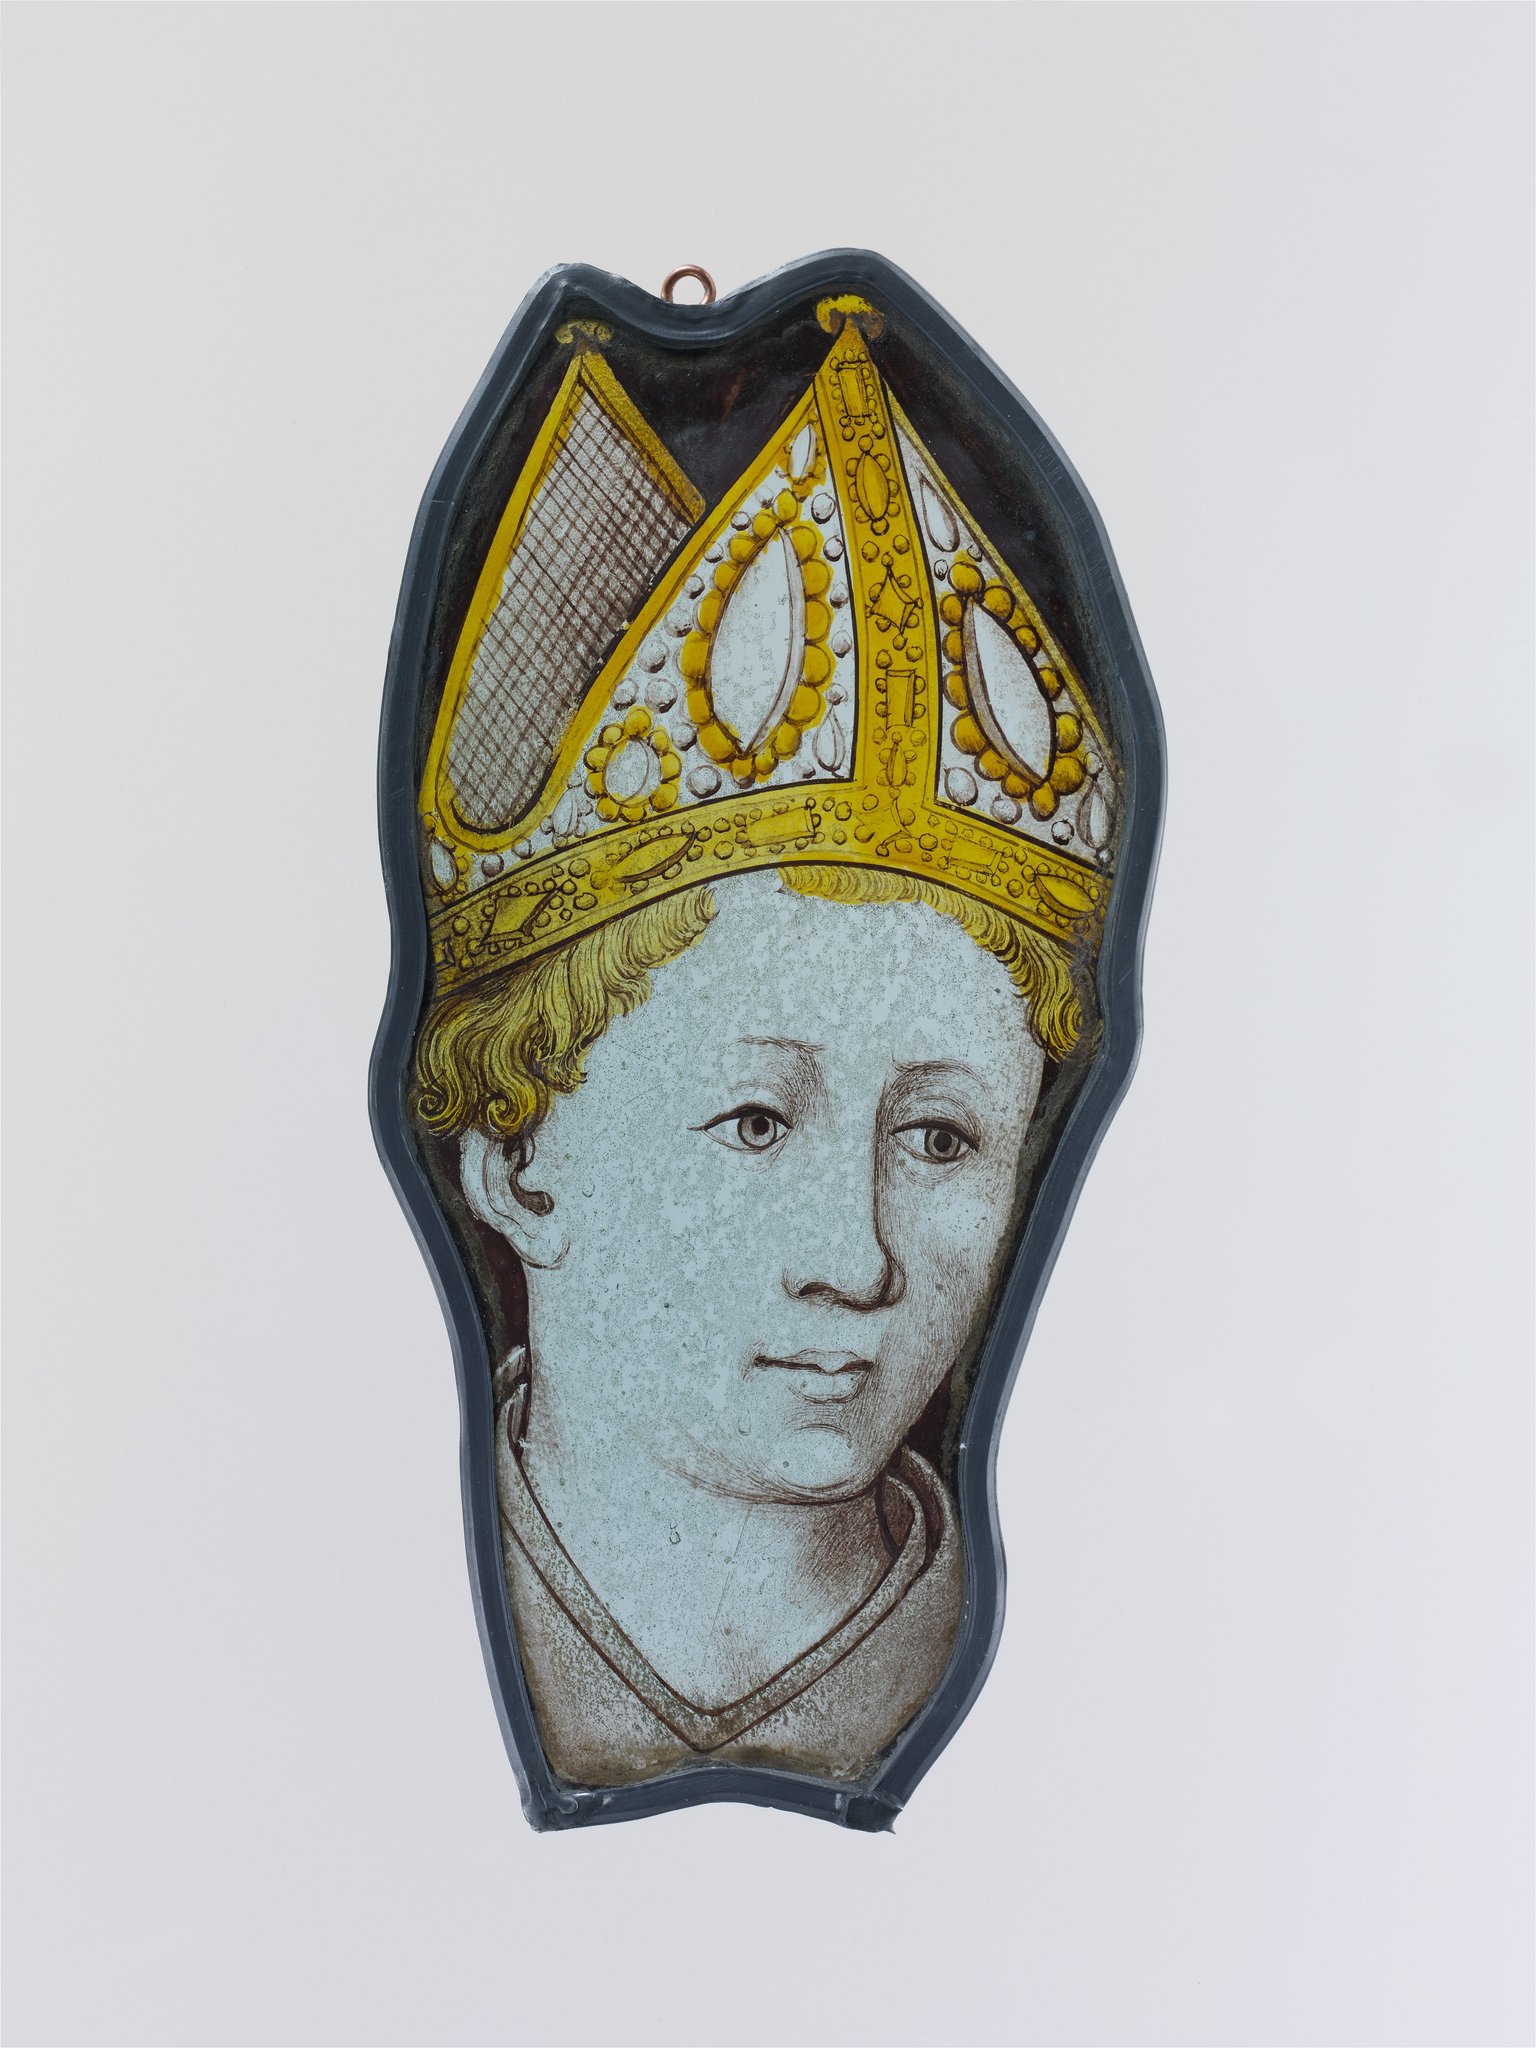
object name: stained glass fragment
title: Panel with the Head of a Bishop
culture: south netherlandish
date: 1440-1460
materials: glass, paint, pigment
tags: heads,men,bishops